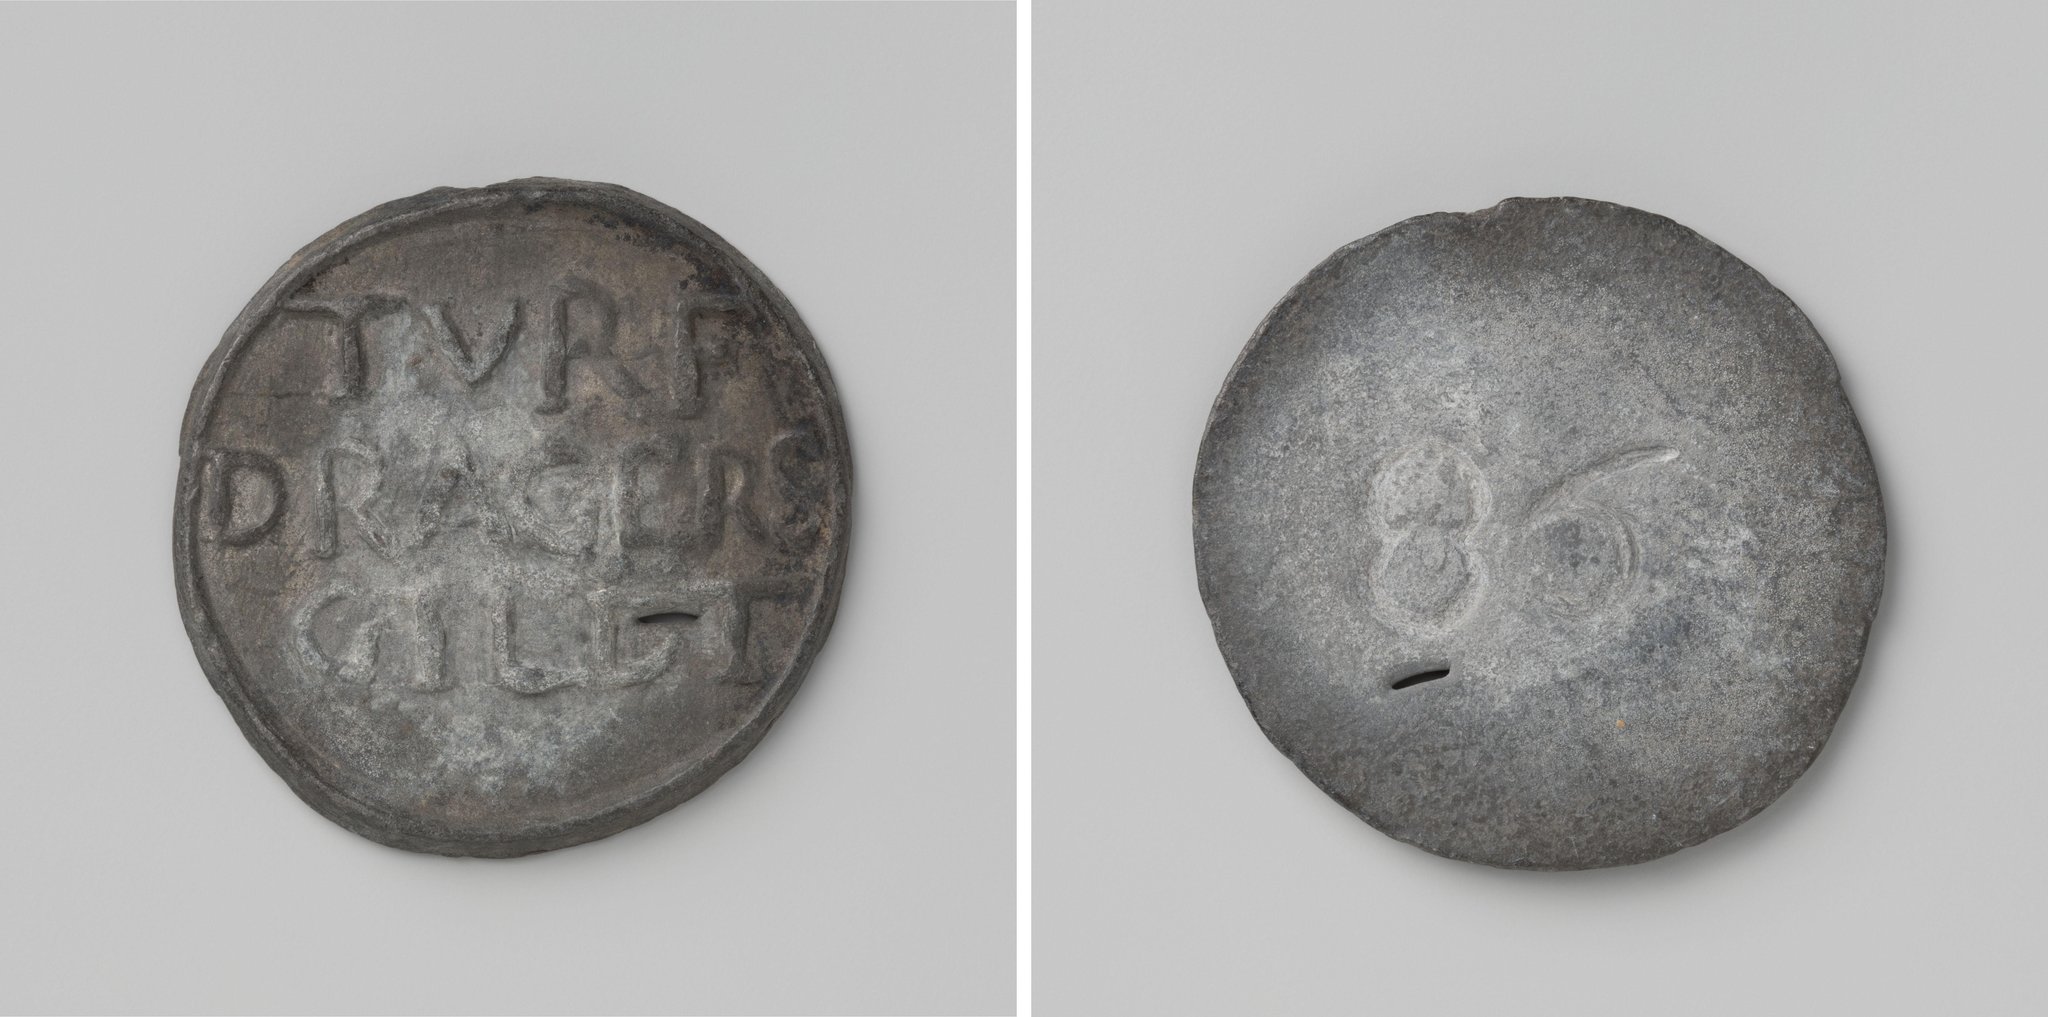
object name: medal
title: Turfdragersgilde van Amsterdam, gildepenning met no. 85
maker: Anonymous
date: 1600-1800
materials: lead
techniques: casting, engraving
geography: amsterdam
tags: amsterdam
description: Loden penning. Voorzijde: opschrift. Keerzijde: cijfer 85